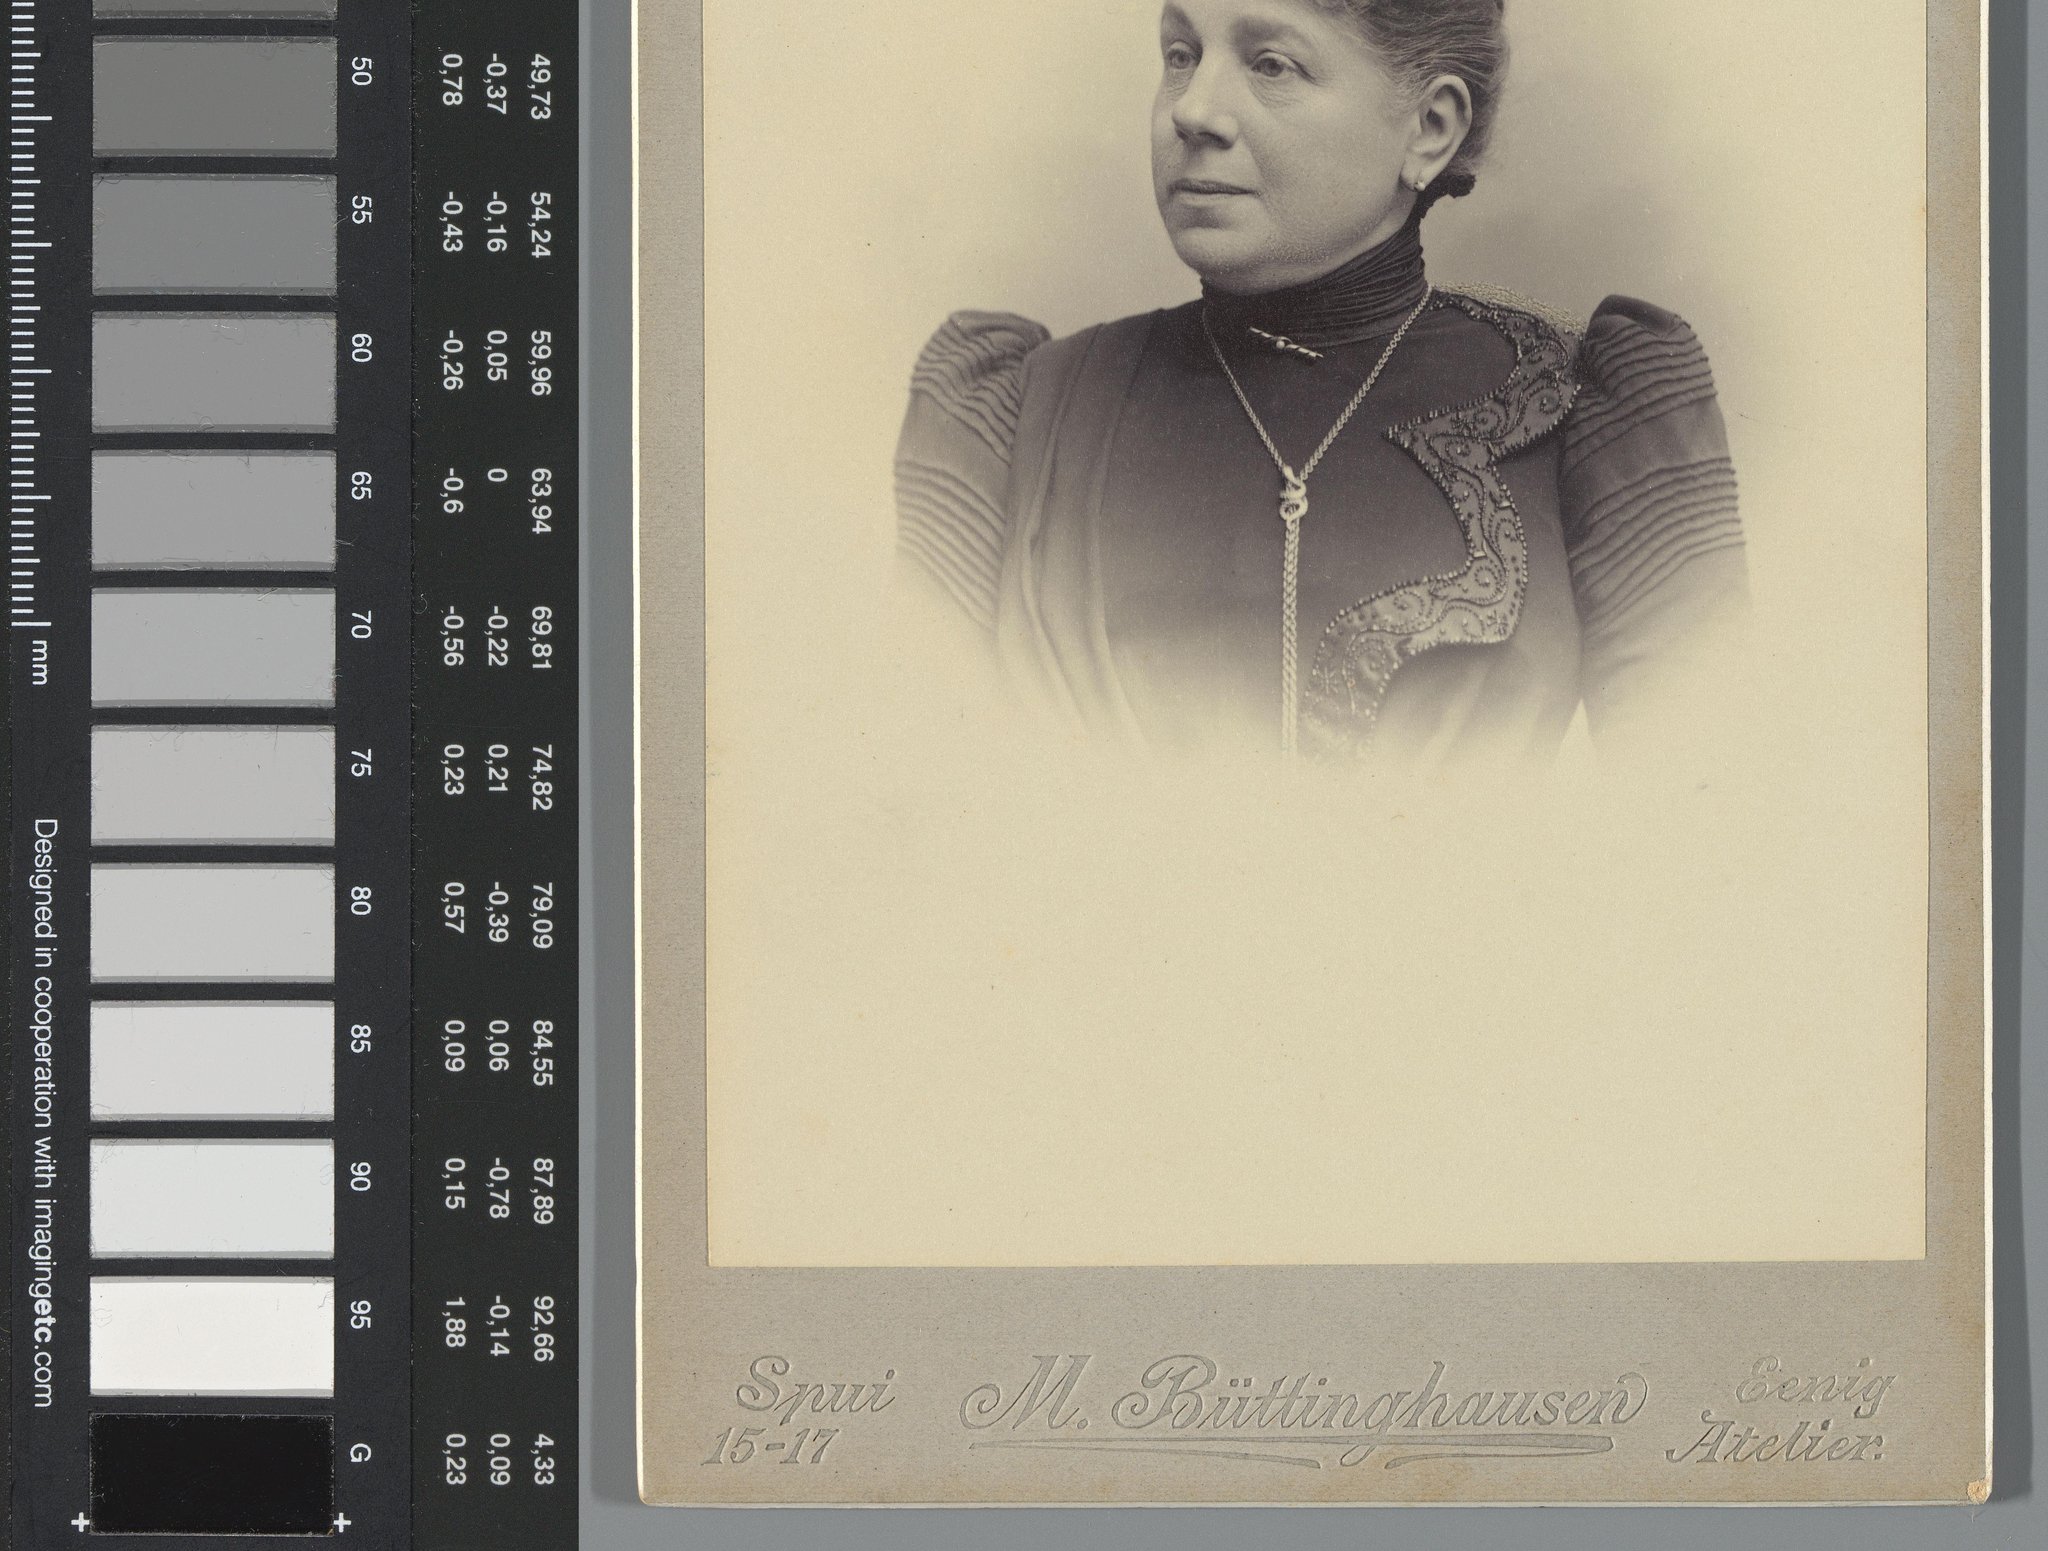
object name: cabinet photograph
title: Portret van Carolina Frederika Holle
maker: max büttinghausen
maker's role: fotograaf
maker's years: 1847-1906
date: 1870-1900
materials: cardboard, photographic support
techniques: albumen print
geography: spui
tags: amsterdam, carolina frederika van den berg-holle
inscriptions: inscription: ‘Spui / 15 - 17 / M. Büttinghausen / Eenig / Atelier.’